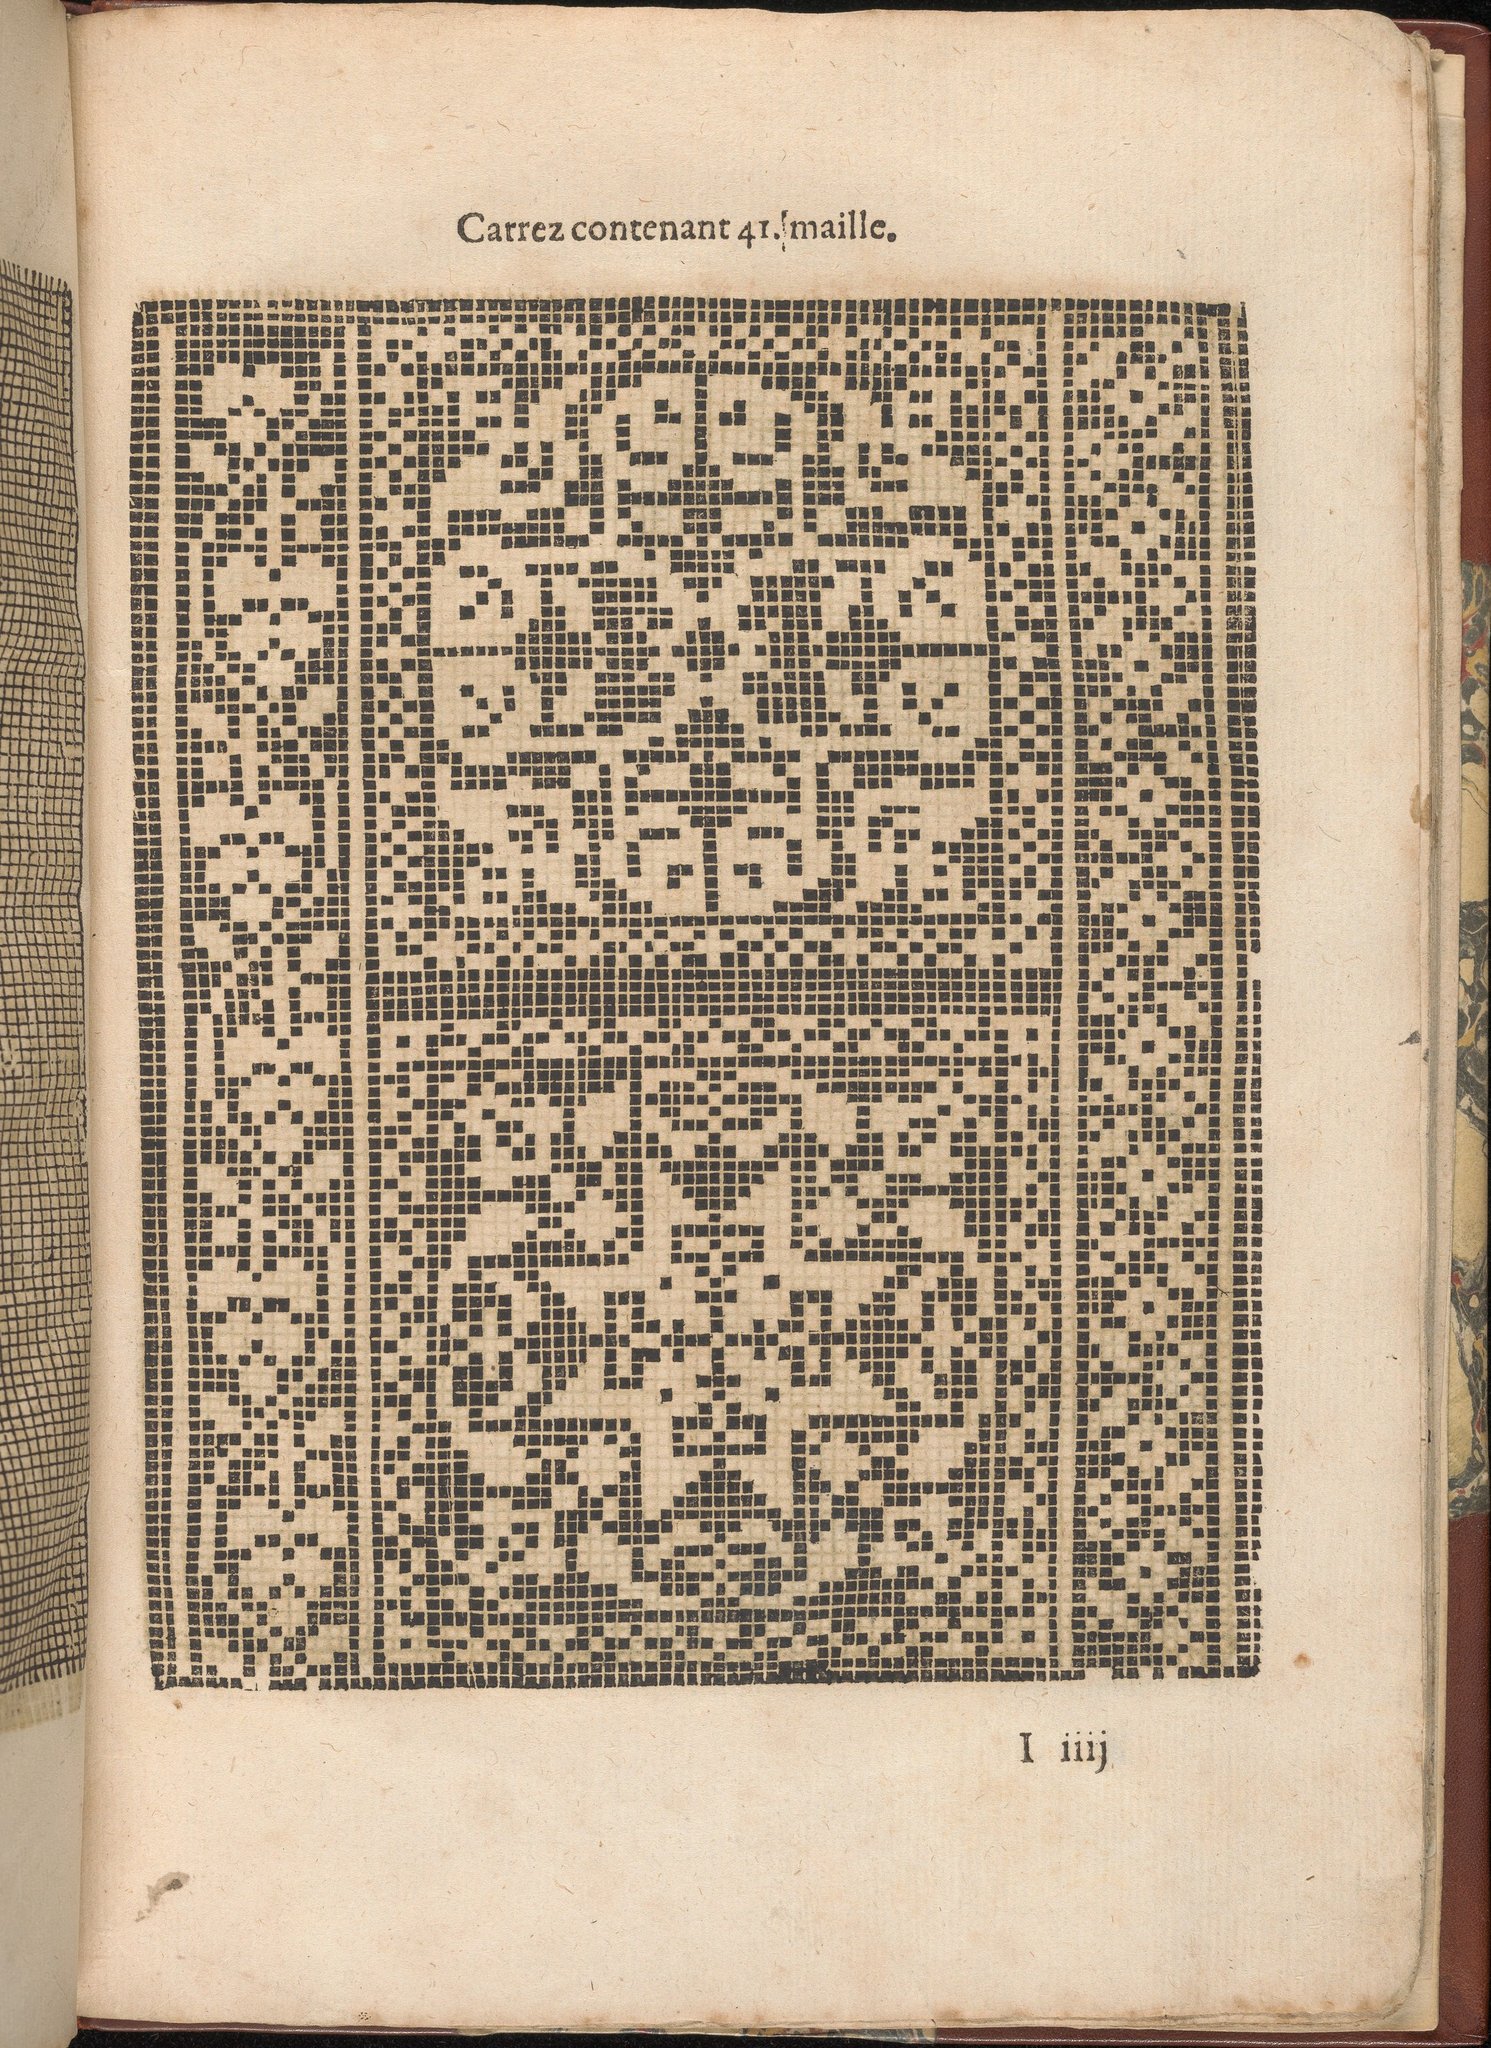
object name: book print ornament architecture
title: Les Secondes Oeuvres, et Subtiles Inventions De Lingerie du Seigneur Federic de Vinciolo Venitien, page 36 (recto)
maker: federico de vinciolo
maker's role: designer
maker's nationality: italian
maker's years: 1582-1599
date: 1603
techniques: woodcut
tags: ornament